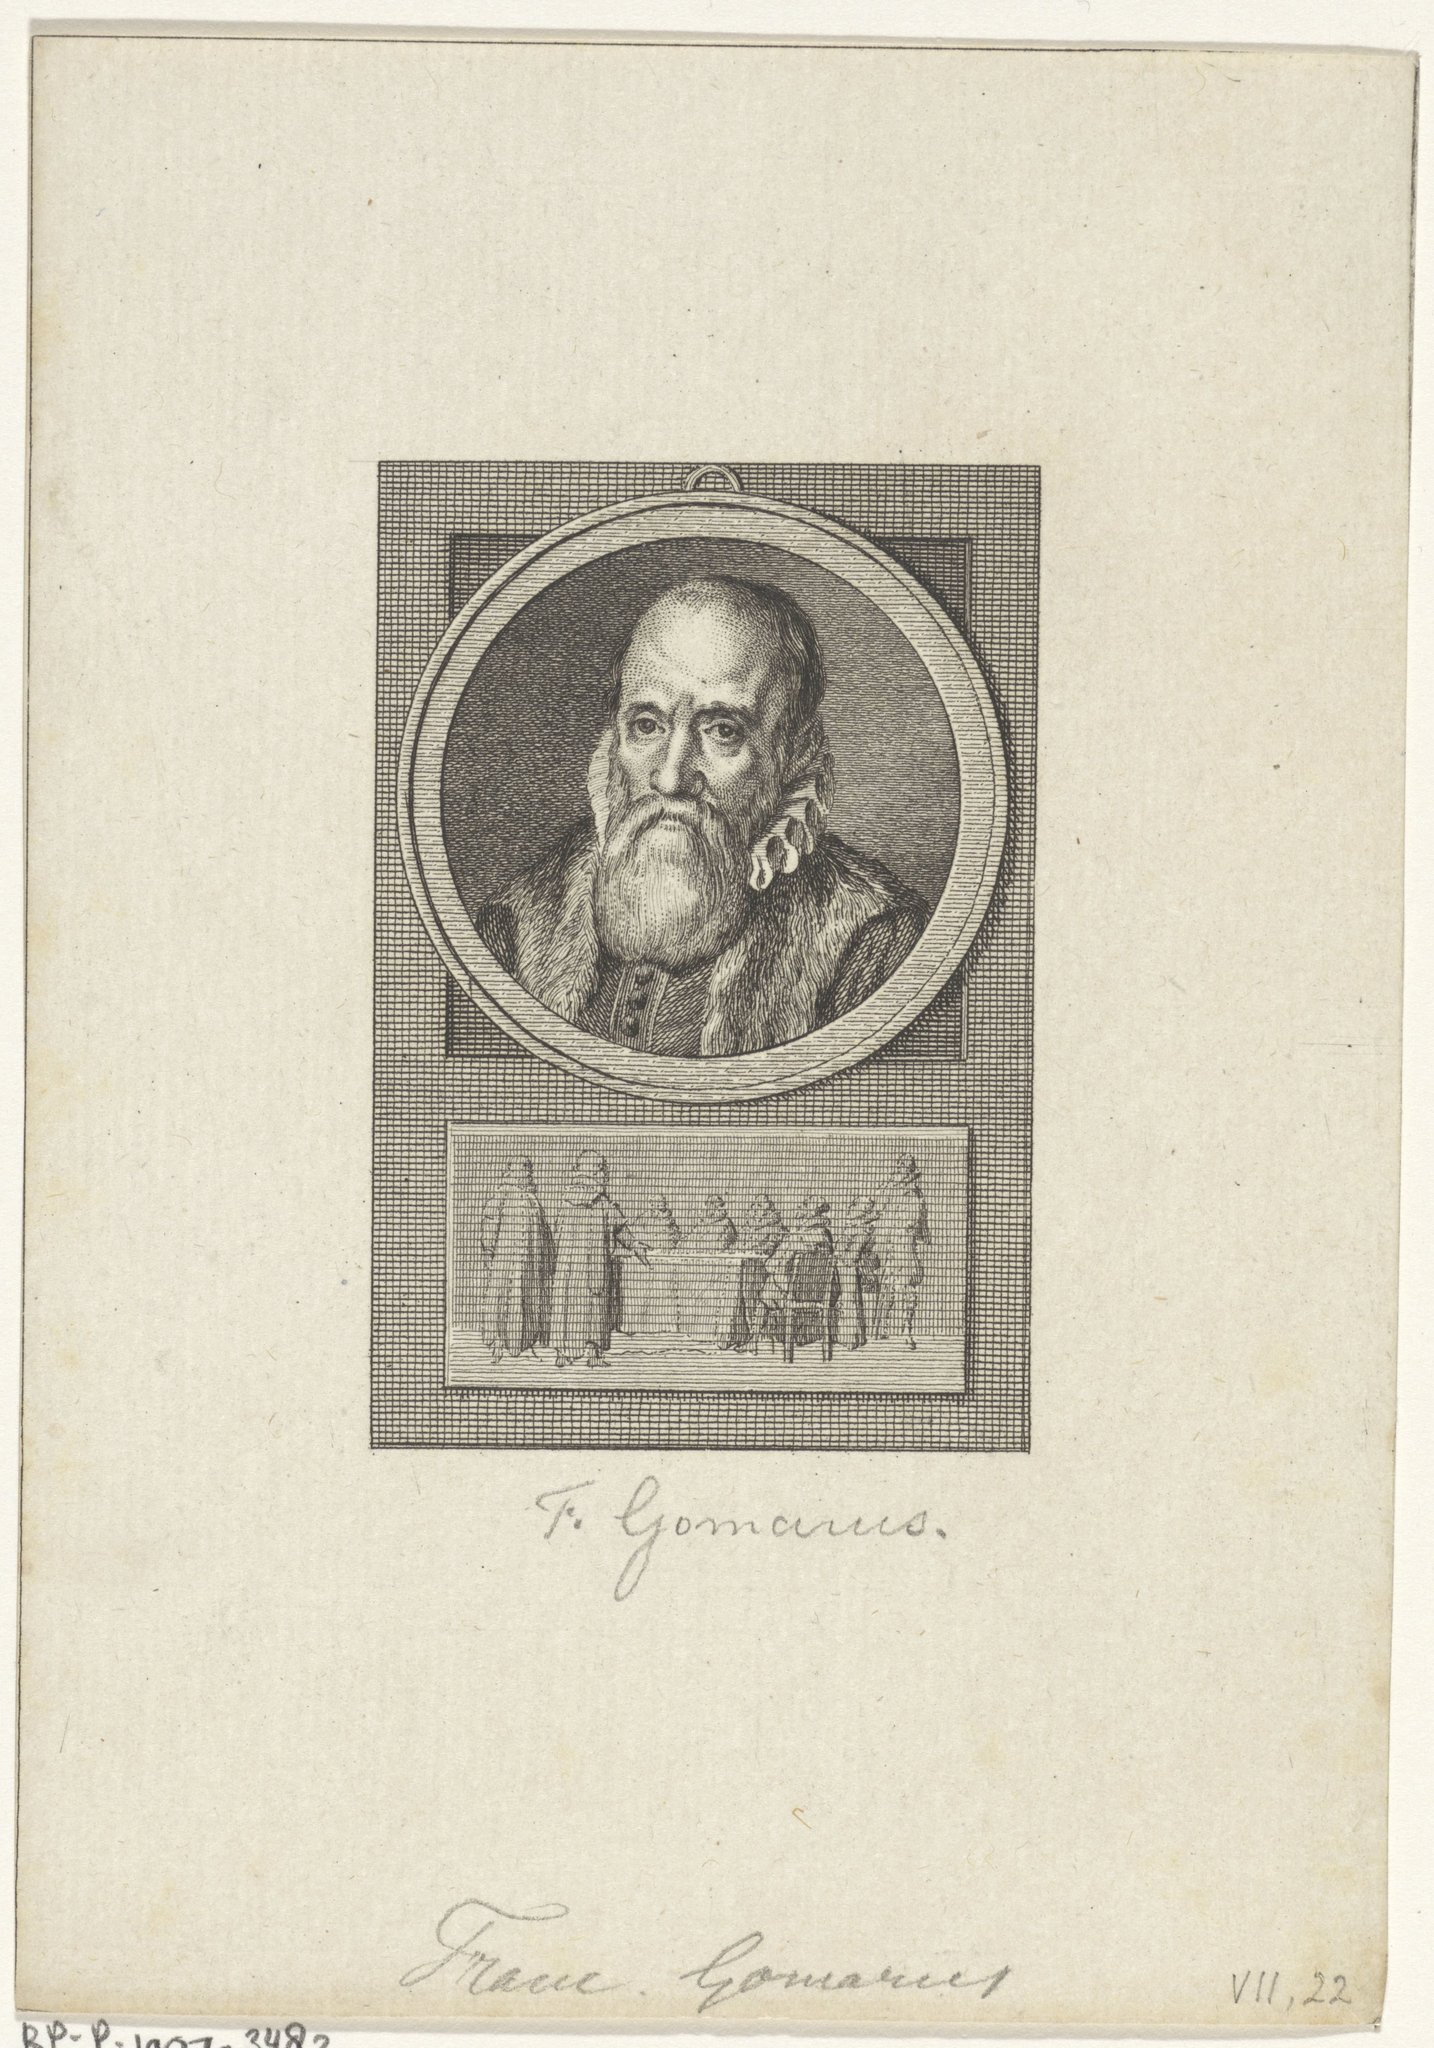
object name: print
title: Portret van Franciscus Gomarus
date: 1783-1795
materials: paper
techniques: engraving, etching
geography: amsterdam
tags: bruges, debate, discussion (~ meeting)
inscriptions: collector's mark: Lugt 2228, inscription: ‘Franc Gomarus VII, 22’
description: Portret van de theoloog Franciscus Gomarus. Onder het portret een afbeelding van de discussie van Gomarus, als leider van de contra-remonstranten, met zijn Leidse collega Jacobus Arminius, voorman van de remonstranten.